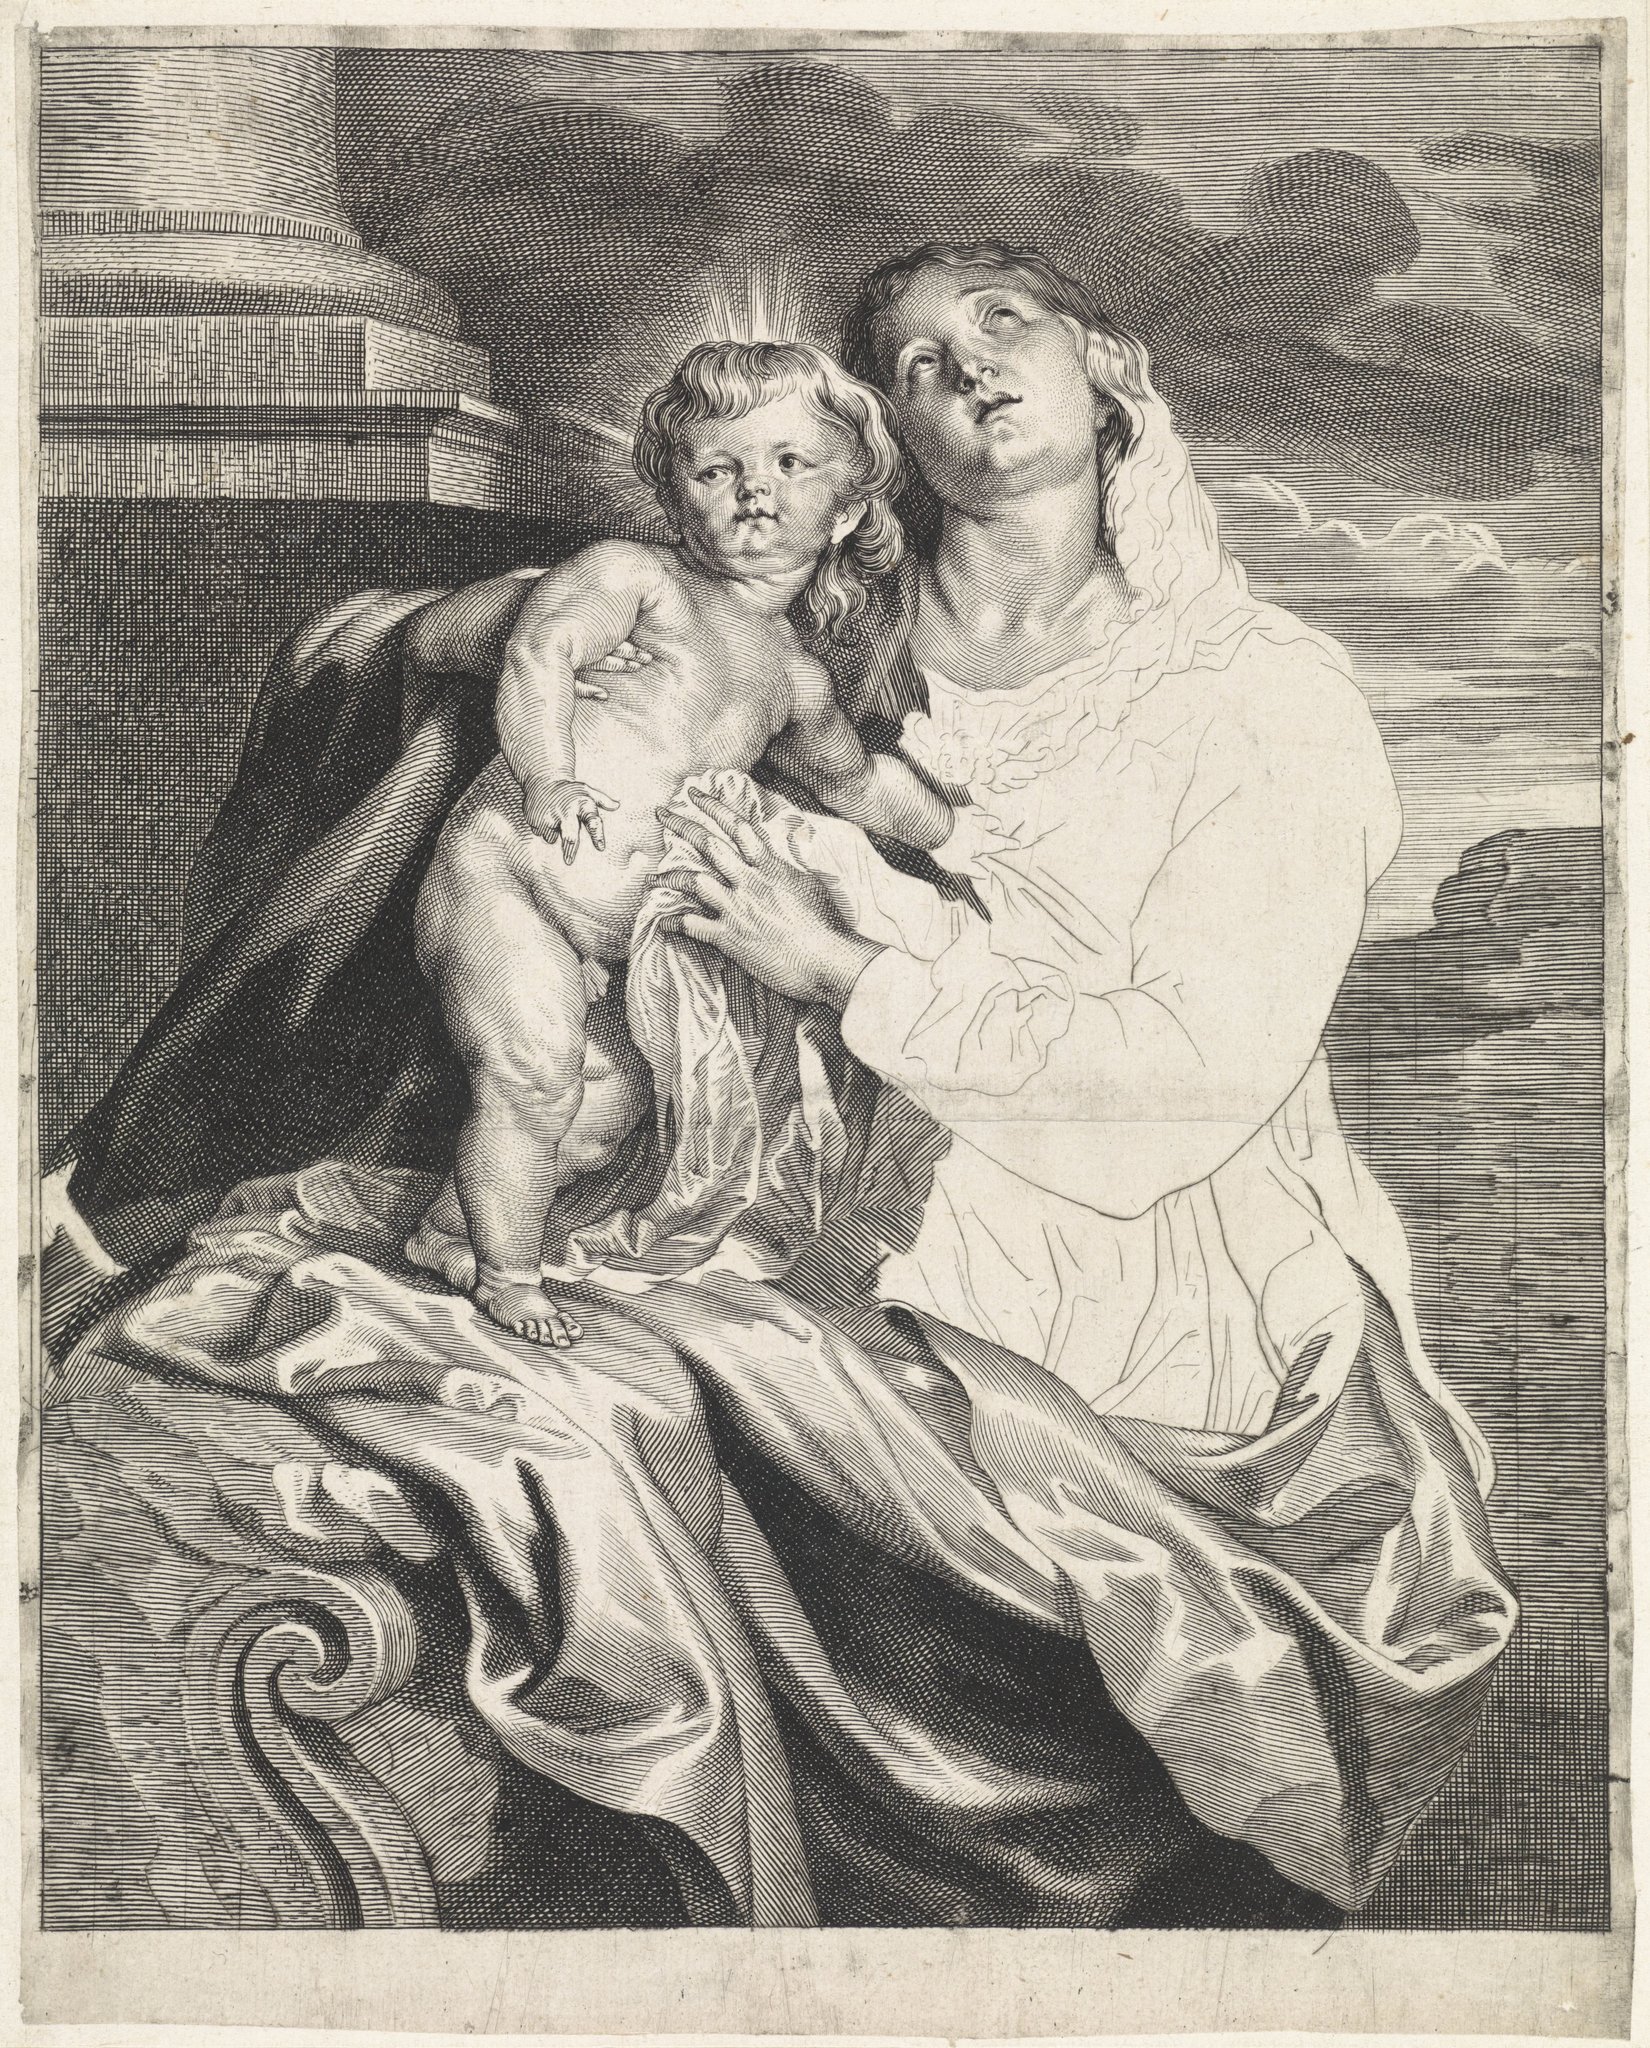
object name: print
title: Maria met het Christuskind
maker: paulus pontius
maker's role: draughtsman, print maker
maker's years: 1603-1658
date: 1616-1657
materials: paper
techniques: engraving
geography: antwerp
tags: mary sitting or enthroned, the christ-child standing on her knee (christ-child to mary's left) - ff - the christ-child to mary's right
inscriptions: collector's mark: Lugt 240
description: Maria kijkt op naar de hemel. Het Christuskind staat op haar schoot. Met een lege marge.